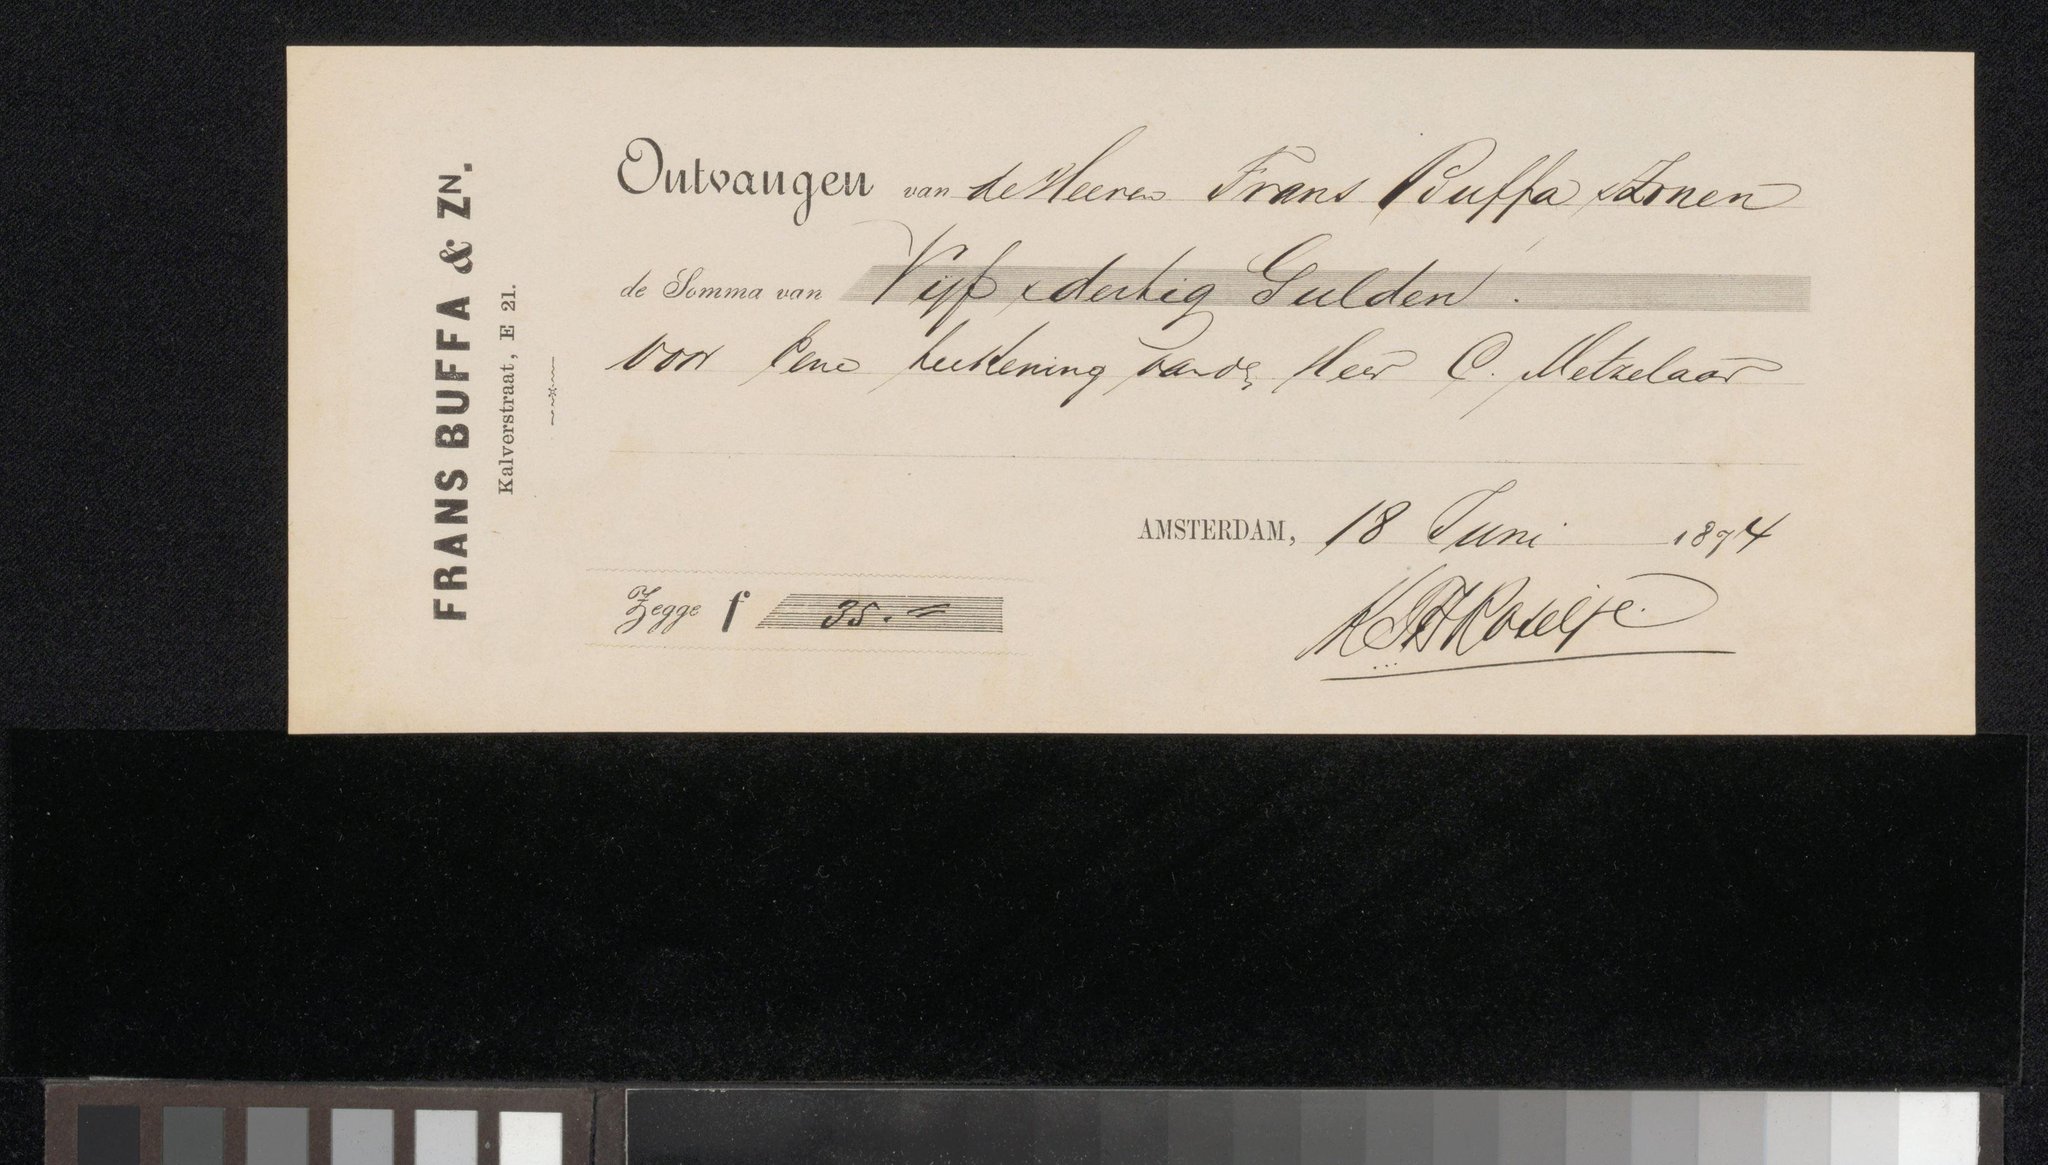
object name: ontvangstbewijs, kwitantie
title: Kwitantie voor onbekend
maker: Anonymous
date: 1874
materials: ink, paper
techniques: pen, printing, writing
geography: amsterdam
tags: drawing, money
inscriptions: collector's mark: Lugt 2233